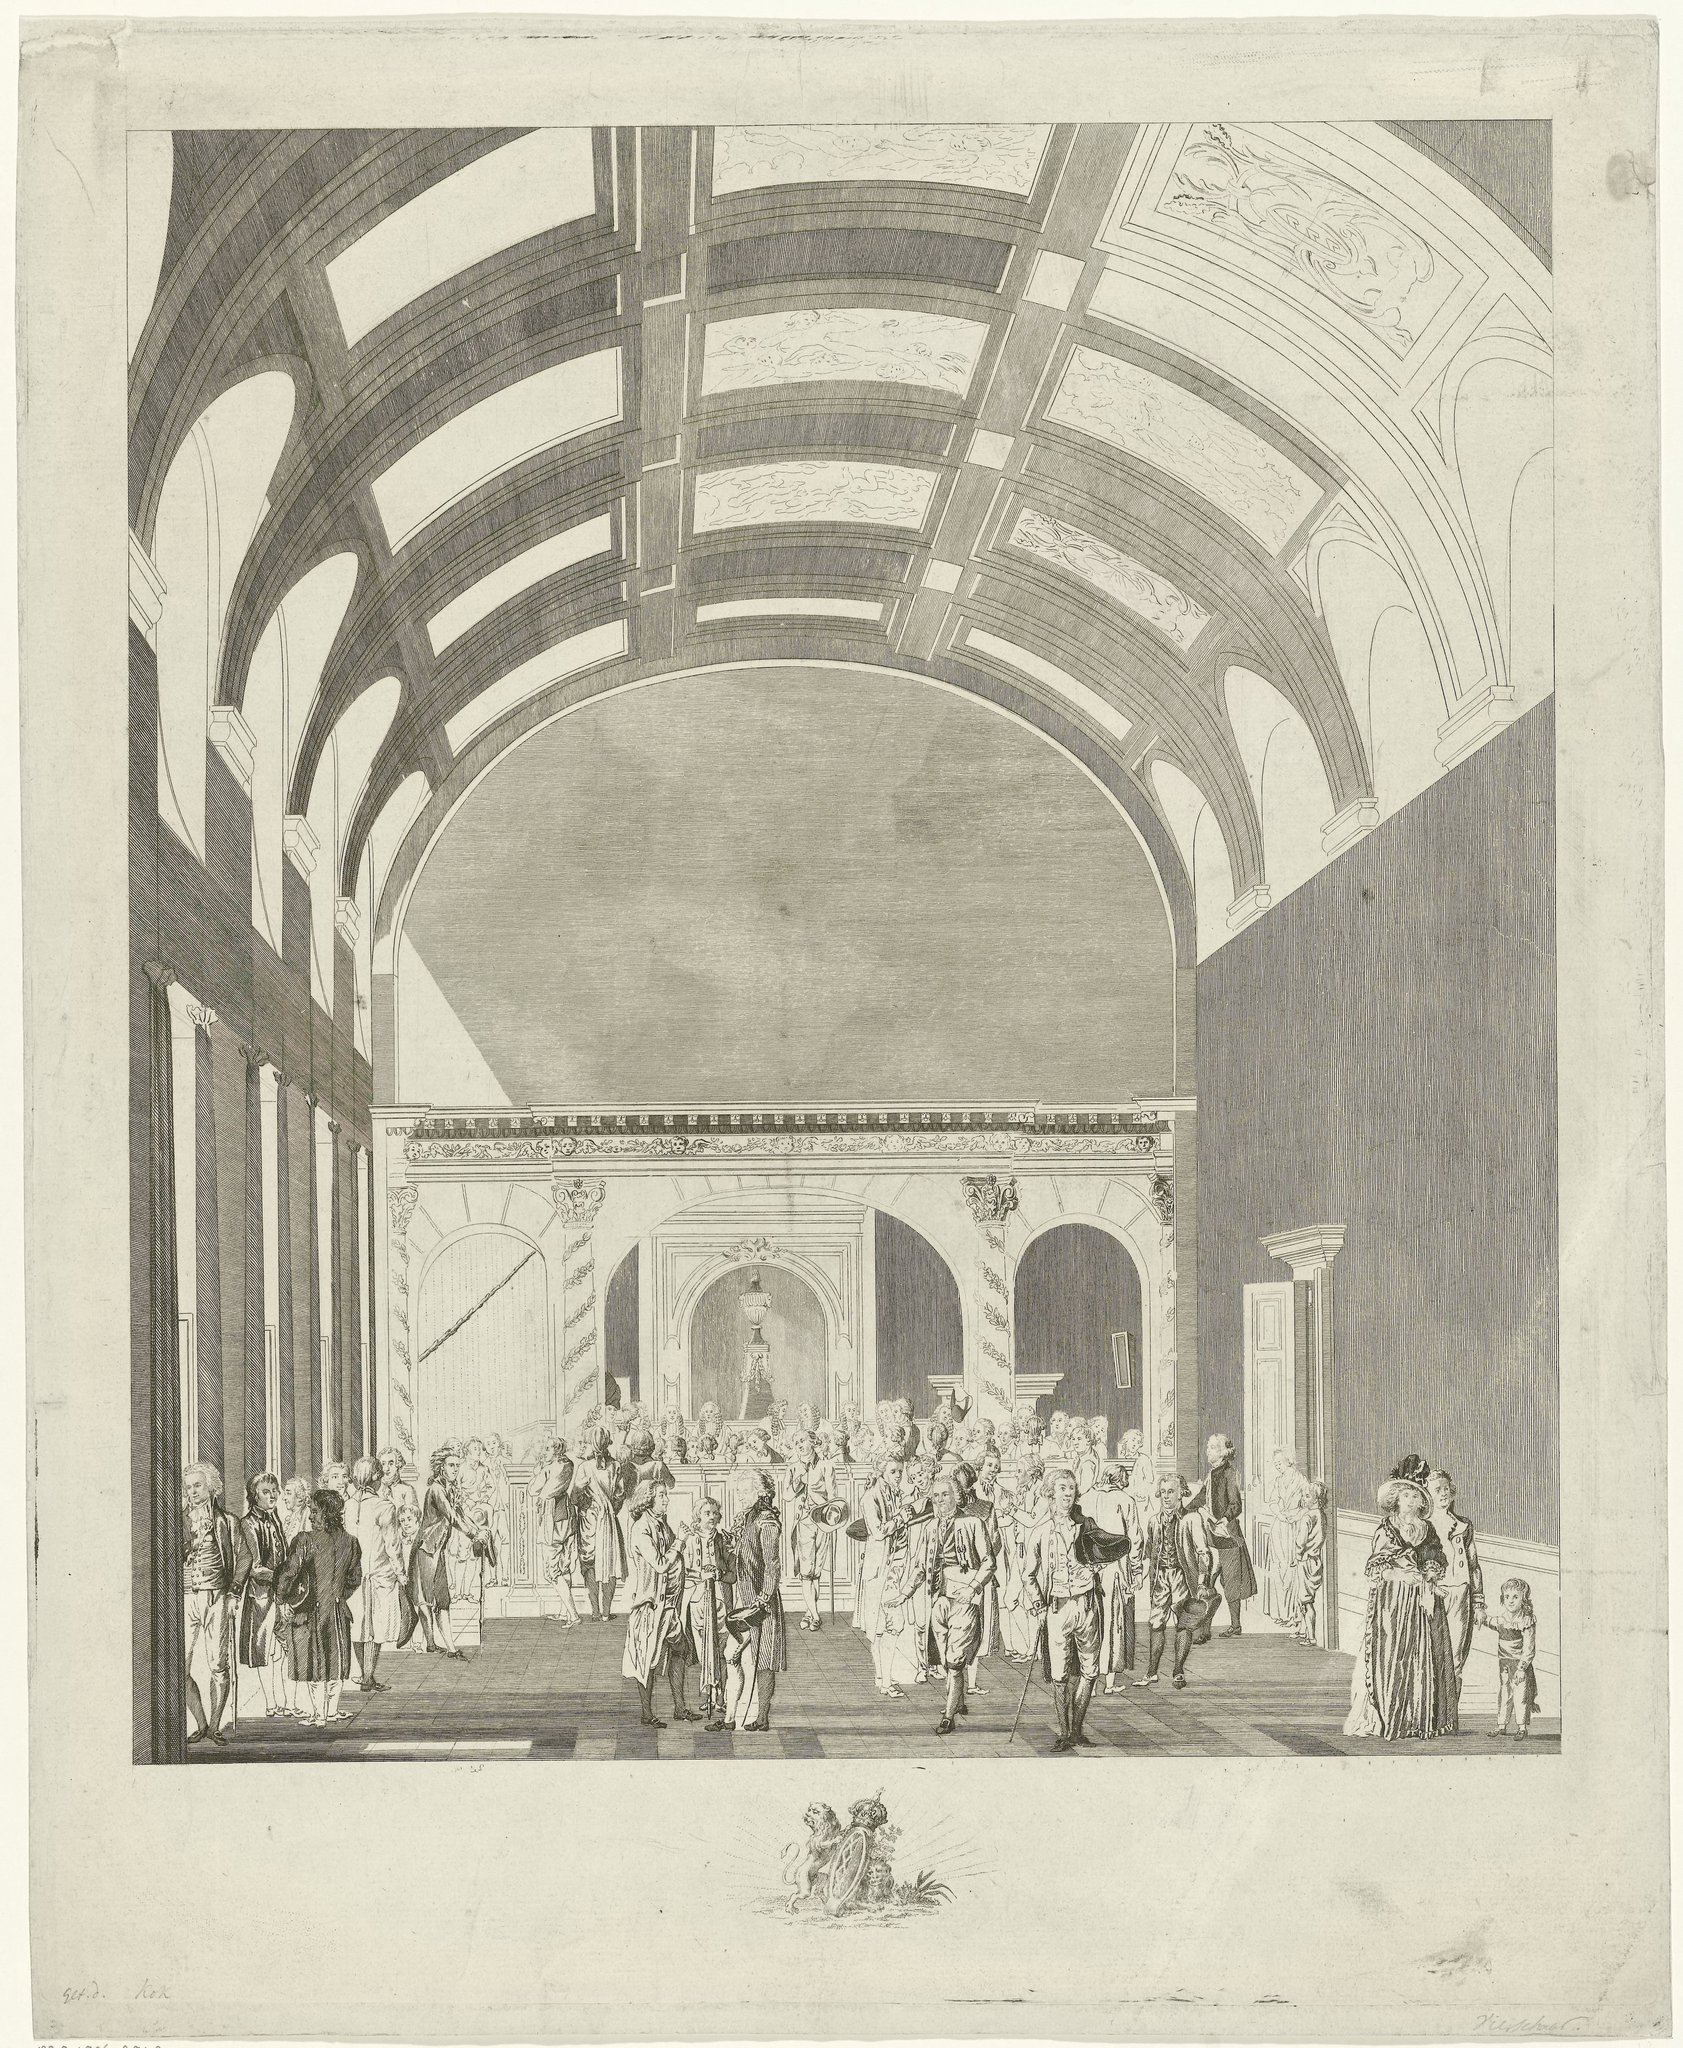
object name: print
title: De Schepens Kamer op het Stadhuis te Amsterdam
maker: willem kok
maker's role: draughtsman, print maker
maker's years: 1761-1807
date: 1793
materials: paper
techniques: etching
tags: dog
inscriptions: inscription: ‘Get.d. Kok’, collector's mark: Lugt 2228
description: In de Schepenzaal van het Stadhuis op de Dam bevinden zich verschillende figuren, voornamelijk mannen. De schepenen zitten in de banken. Enkele figuren zijn met elkaar in gesprek en anderen lijken het interieur te bewonderen. Op het plafon zijn de familiewapens van de eerste schepenen te zien. Onder de afbeelding het gekroonde wapen van Amsterdam, vastgehouden door de Nederlandse leeuw.